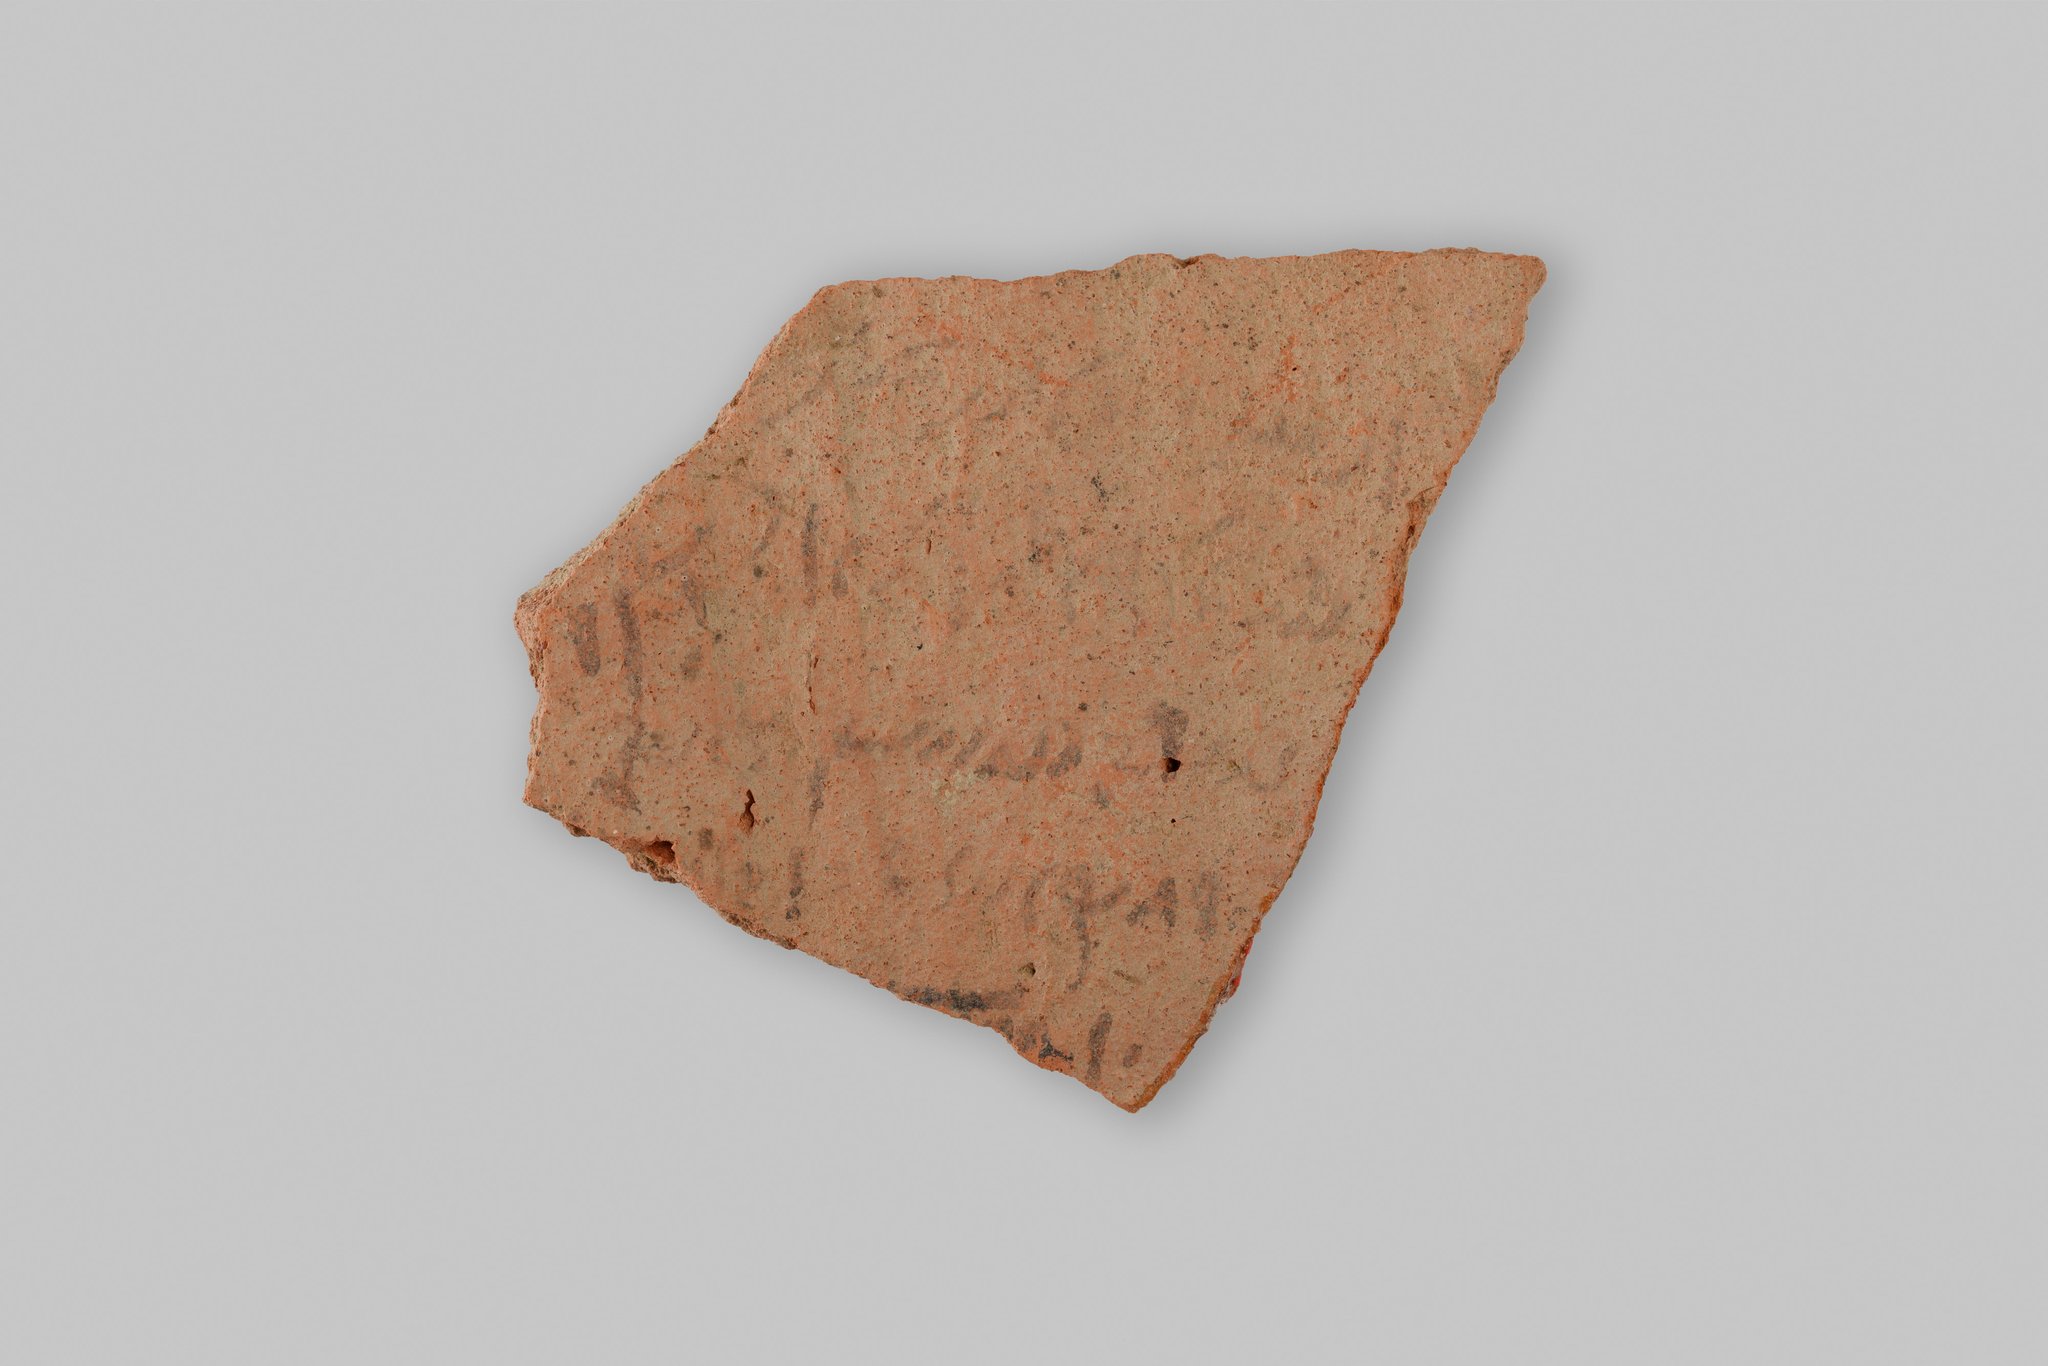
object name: ostracon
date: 400-30 BCE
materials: ink, pottery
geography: egypt